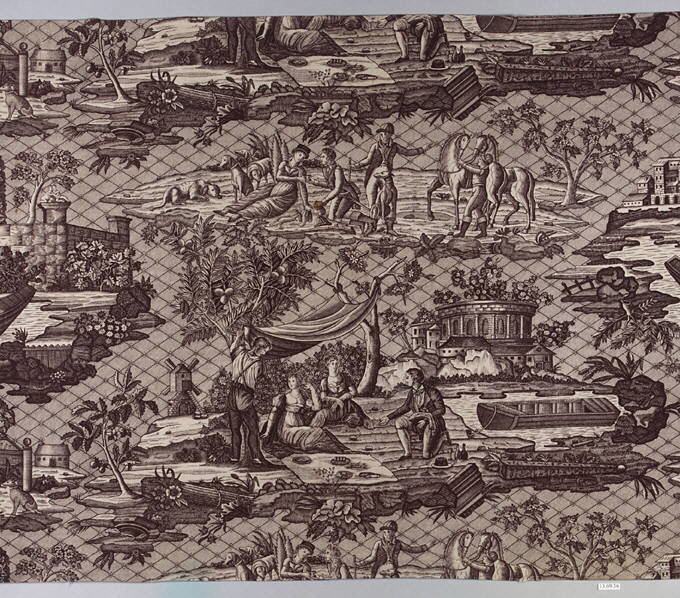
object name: furnishing textile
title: "Pleasures of Summer"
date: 1815-1825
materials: cotton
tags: buildings,men,women,horses,summer